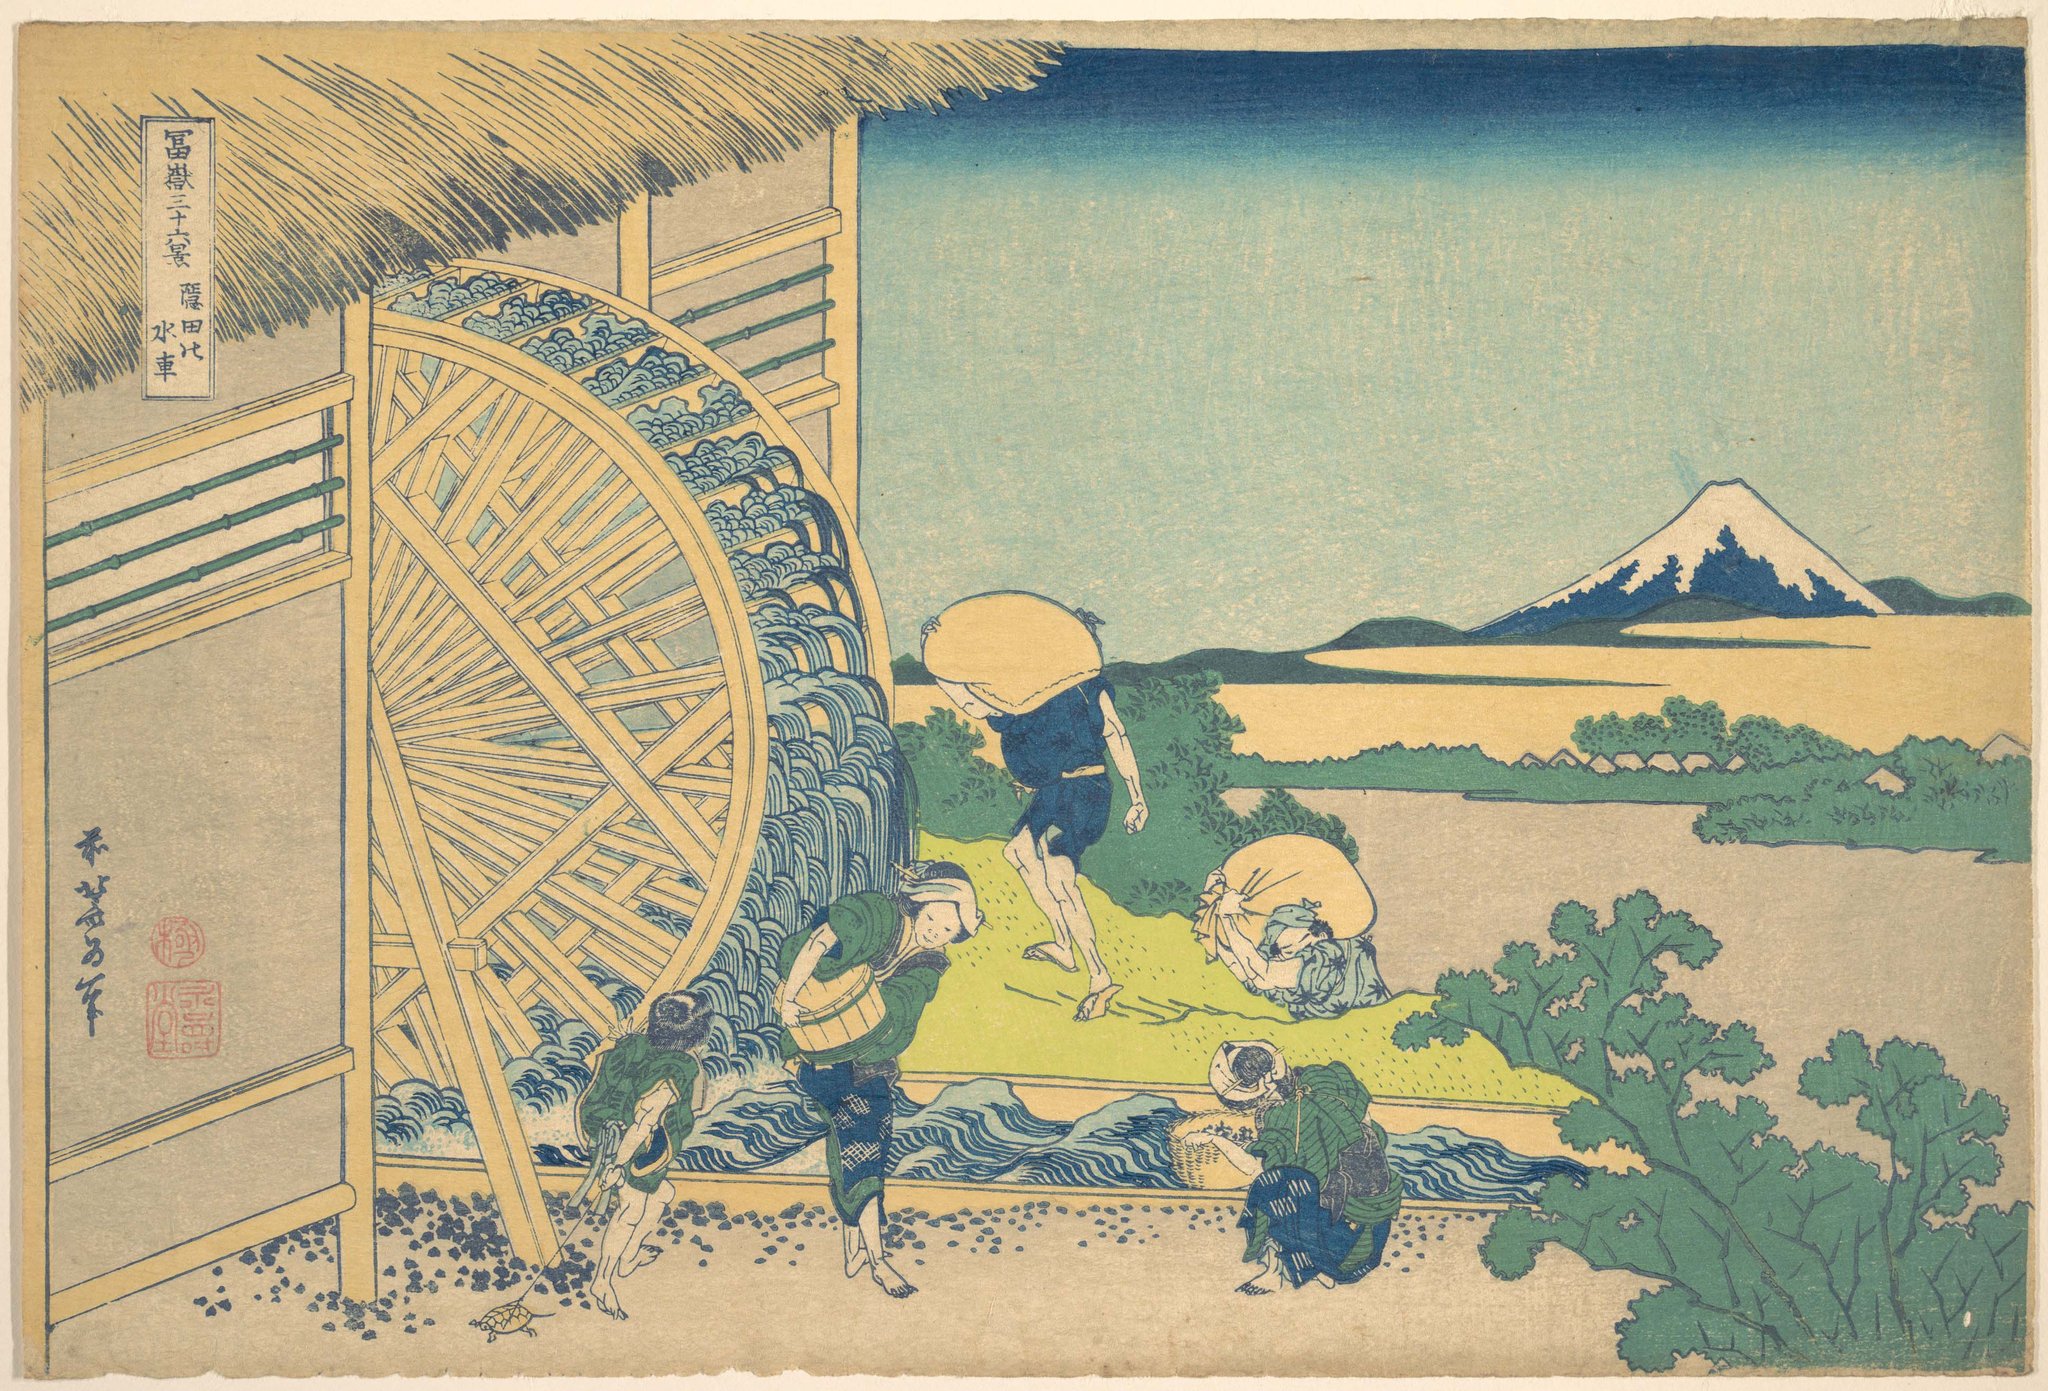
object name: woodblock print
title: The Waterwheel at Onden (Onden no suisha), from the series Thirty-six Views of Mount Fuji (Fugaku sanjūrokkei)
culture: japanese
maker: katsushika hokusai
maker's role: artist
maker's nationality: japanese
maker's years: 1760-1849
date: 1830-1832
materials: ink, paper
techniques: woodblock print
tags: human figures,watermills,working